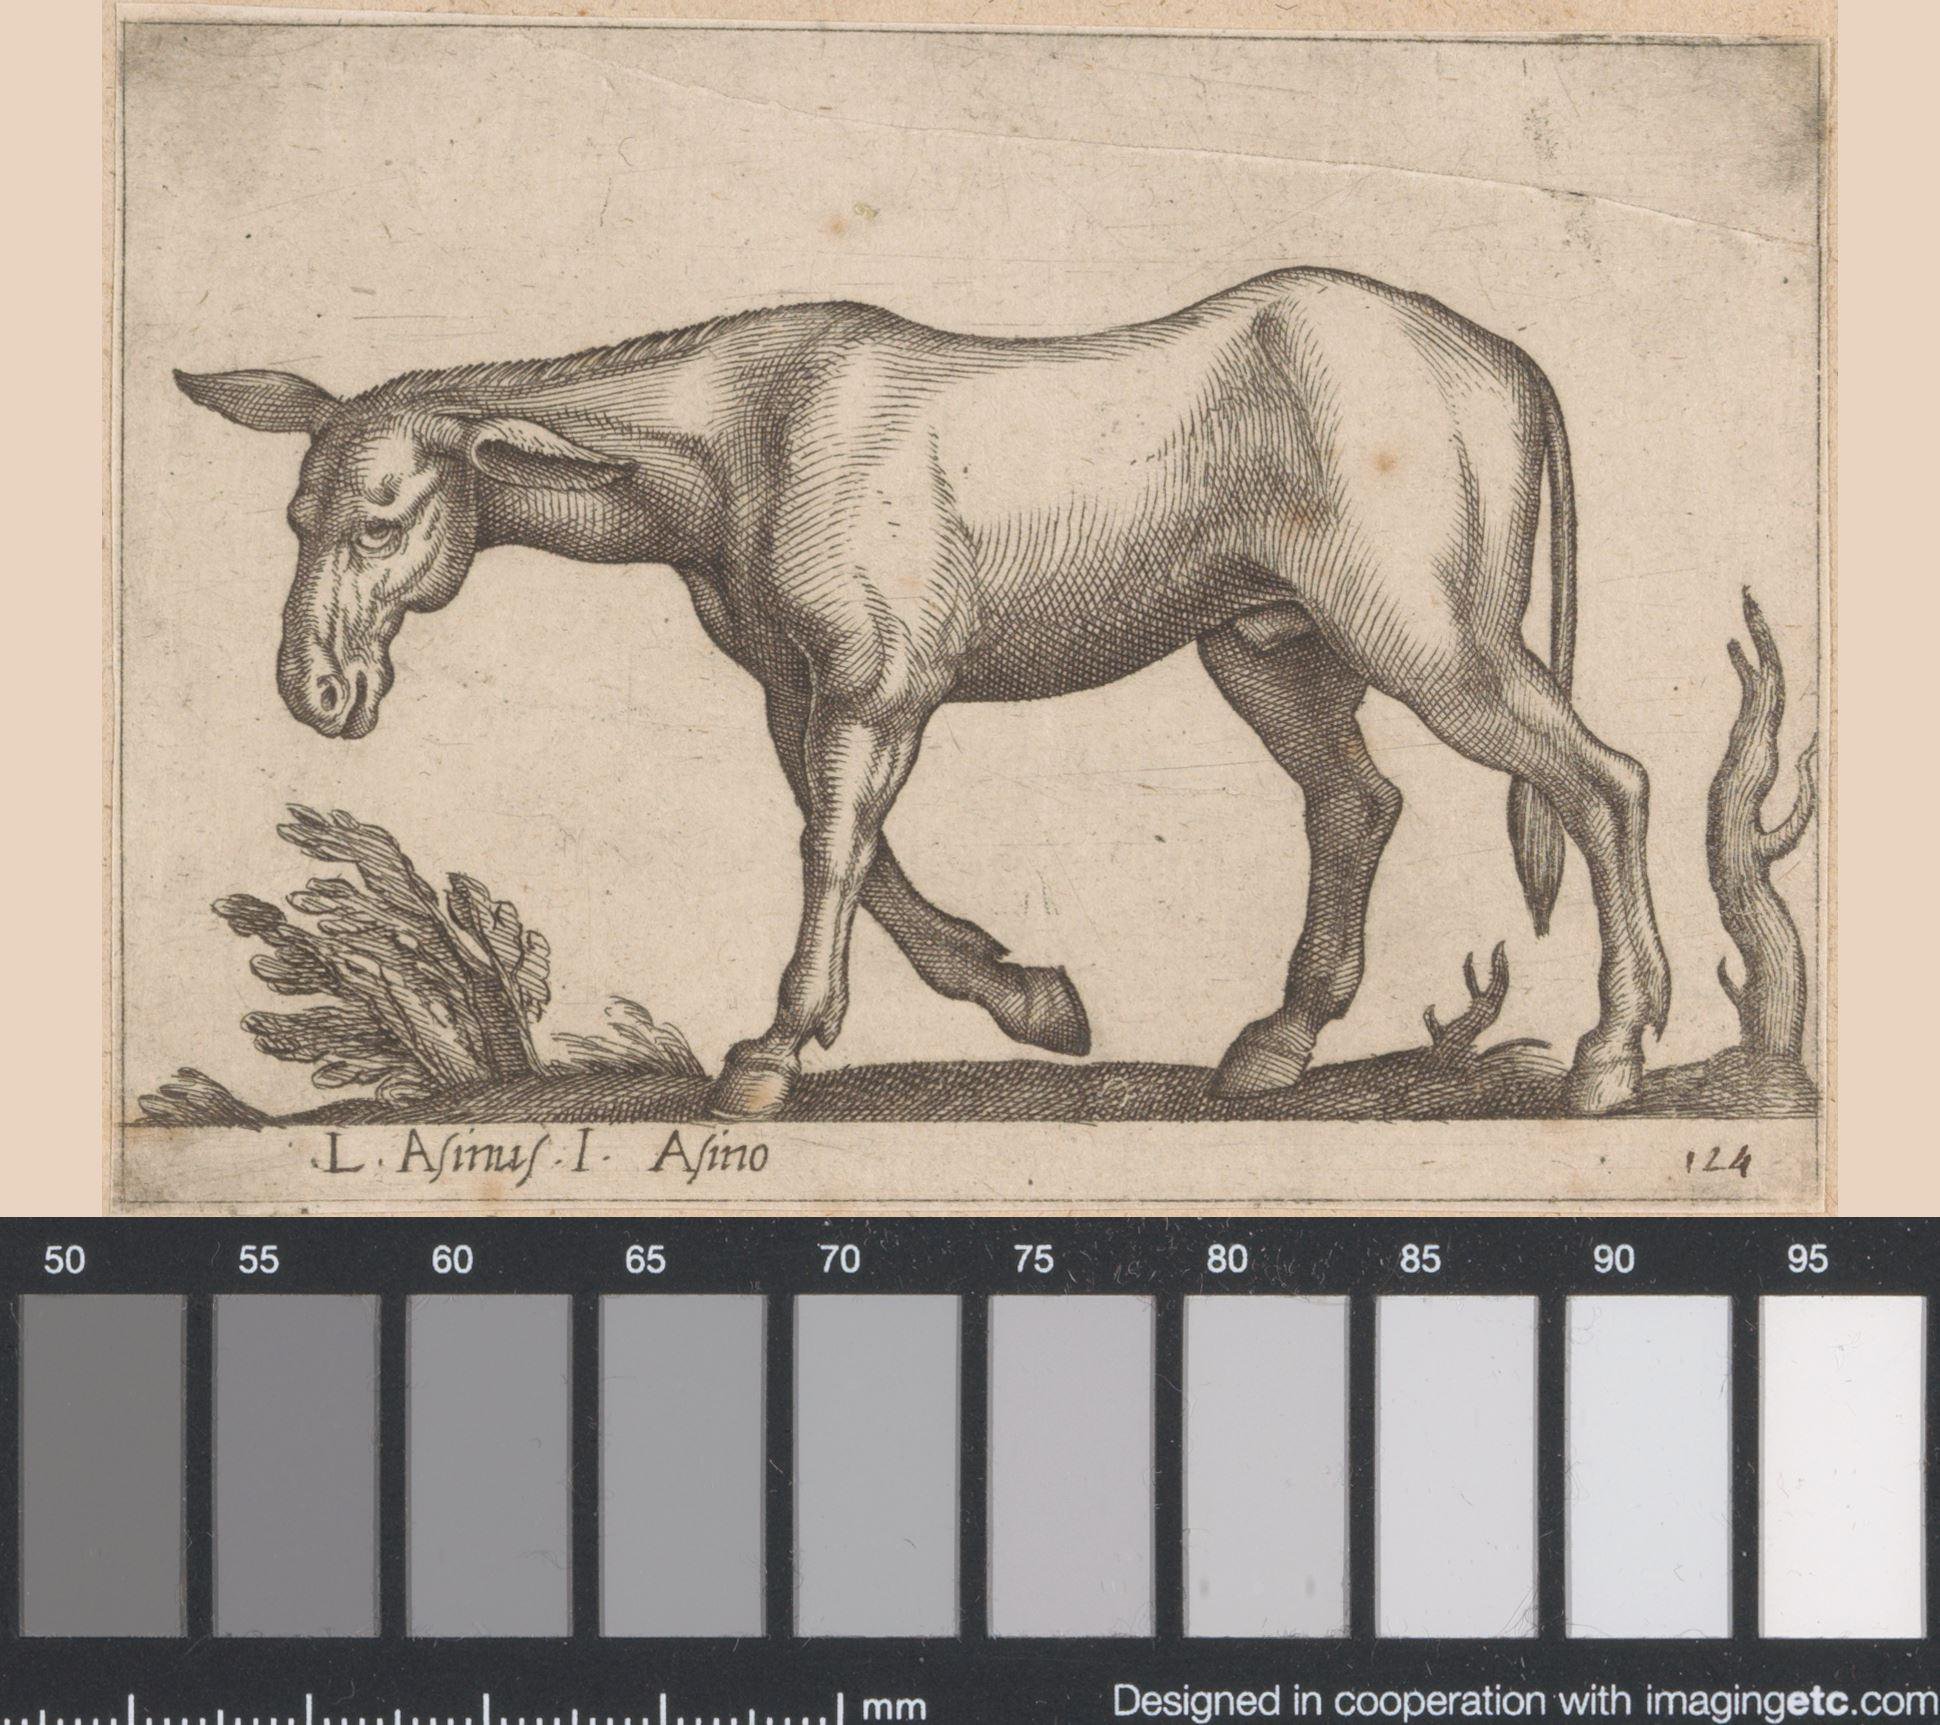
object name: print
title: L Asinus/ I Asino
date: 1565-1630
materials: paper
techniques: etching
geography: rome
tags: ass, donkey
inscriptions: number: ‘124’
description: Deze prent maakt deel uit van een reeks prenten van dieren door Antonio Tempesta. Bekend is dat een tweede staat (met nummering) van deze serie is uitgegeven door Giovanni Giacomo de' Rossi in 1650. Onbekend is wie de eerste staat heeft uitgegeven en wanneer.